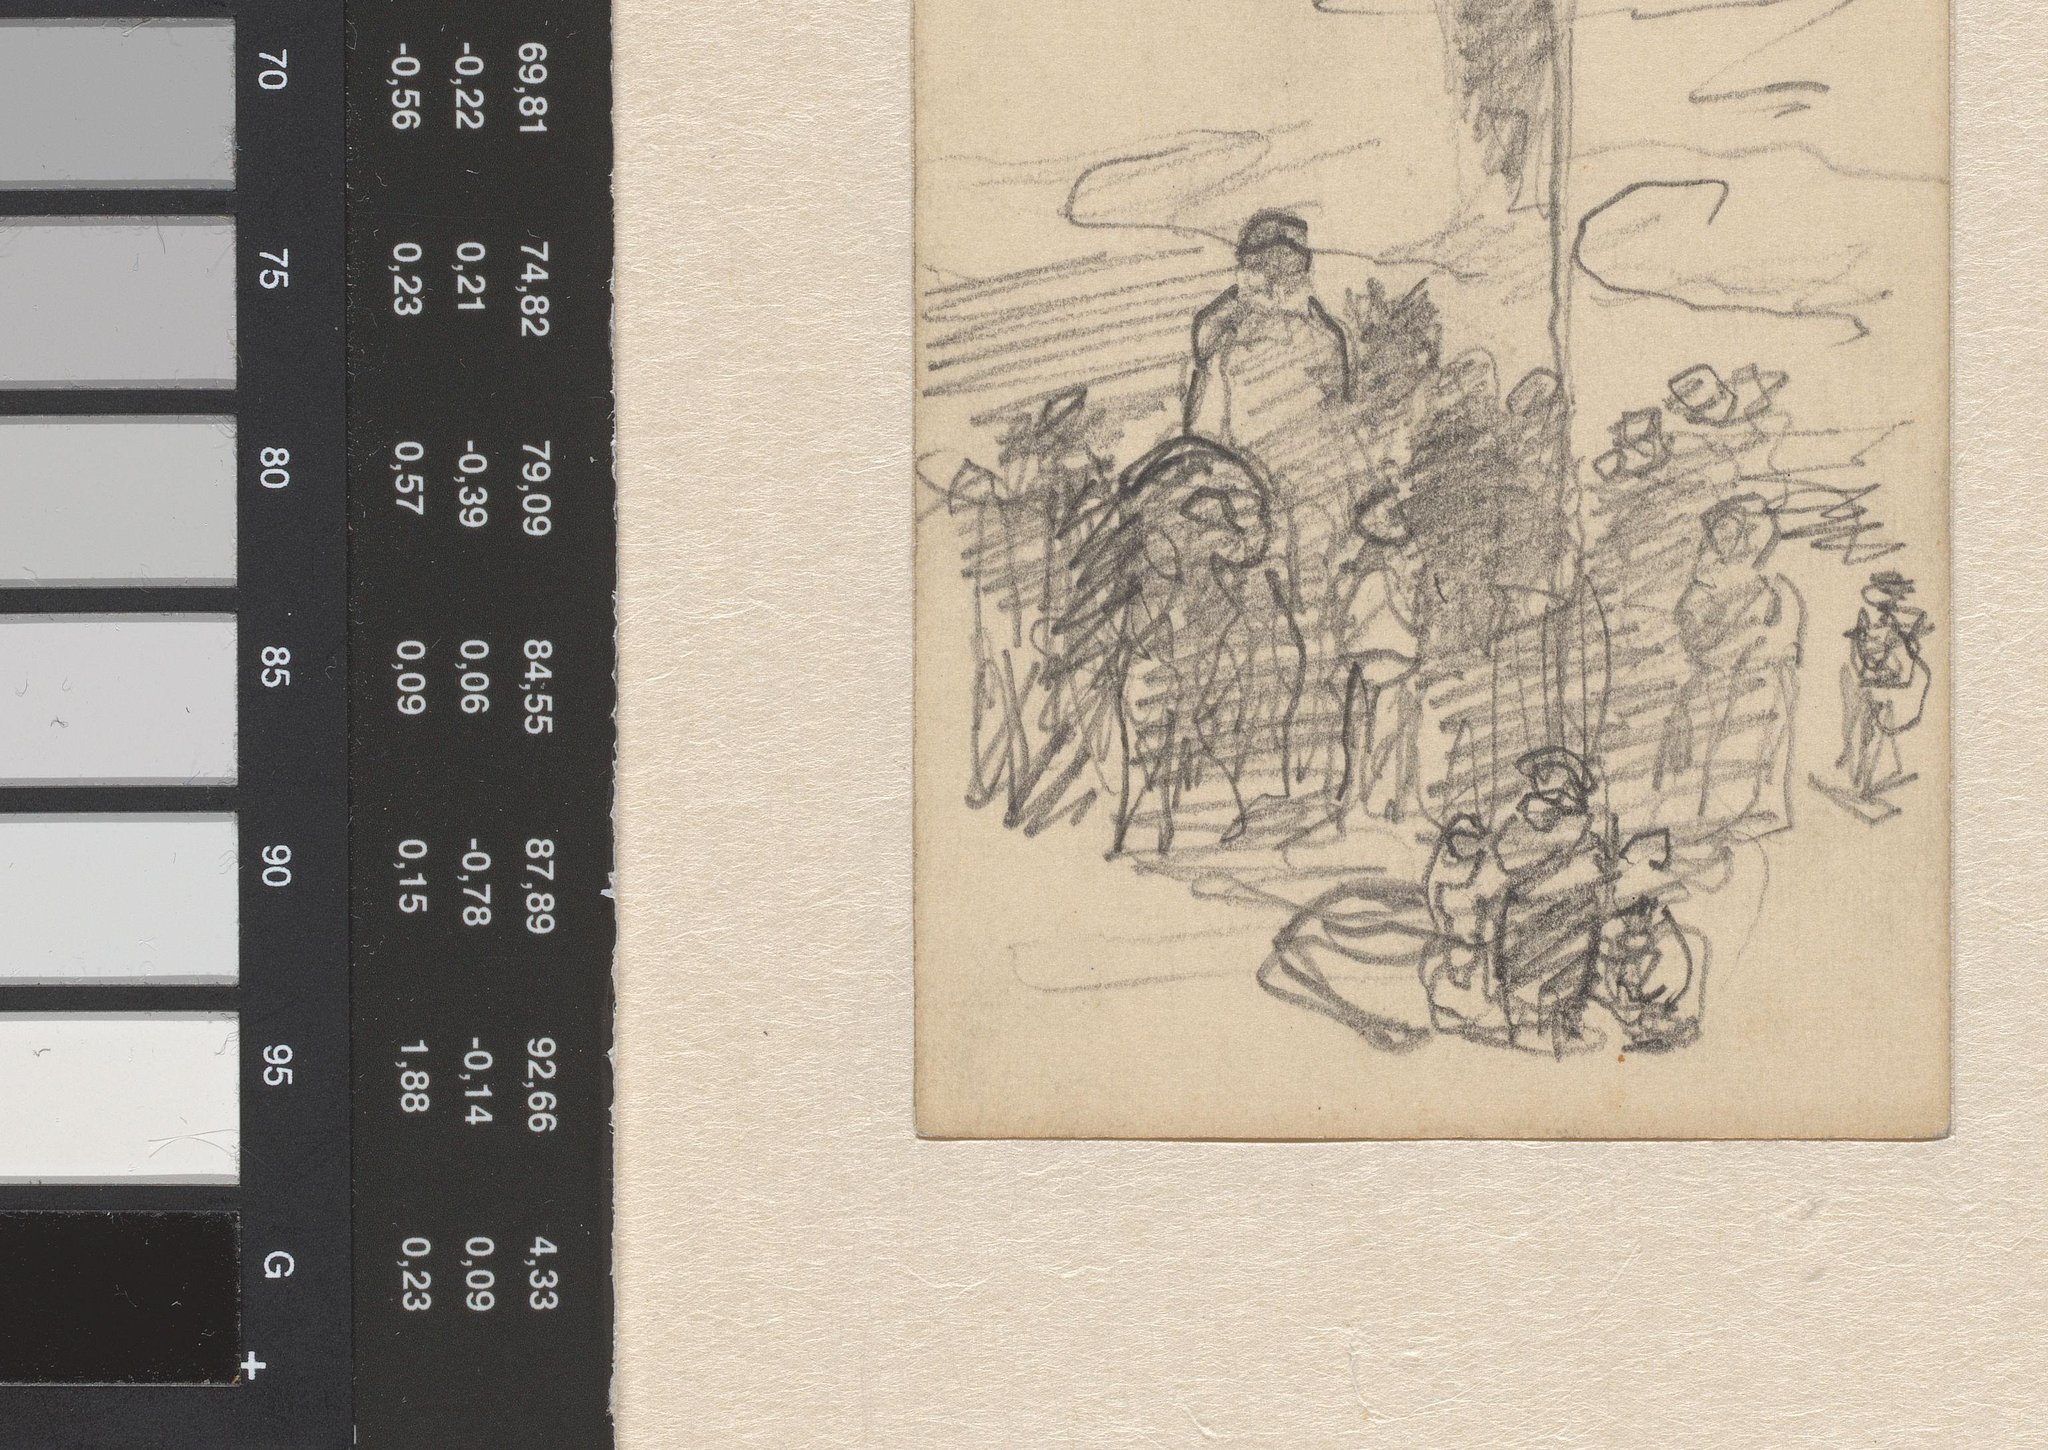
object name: visiting card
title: Groep mensen rond een vlag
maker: sientje mesdag-van houten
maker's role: draughtsman, painter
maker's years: 1834-1909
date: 1870-1909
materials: cardboard, pencil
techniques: printing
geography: netherlands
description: Tekening op een visitekaartje van Sientje Mesdag-Van Houten.